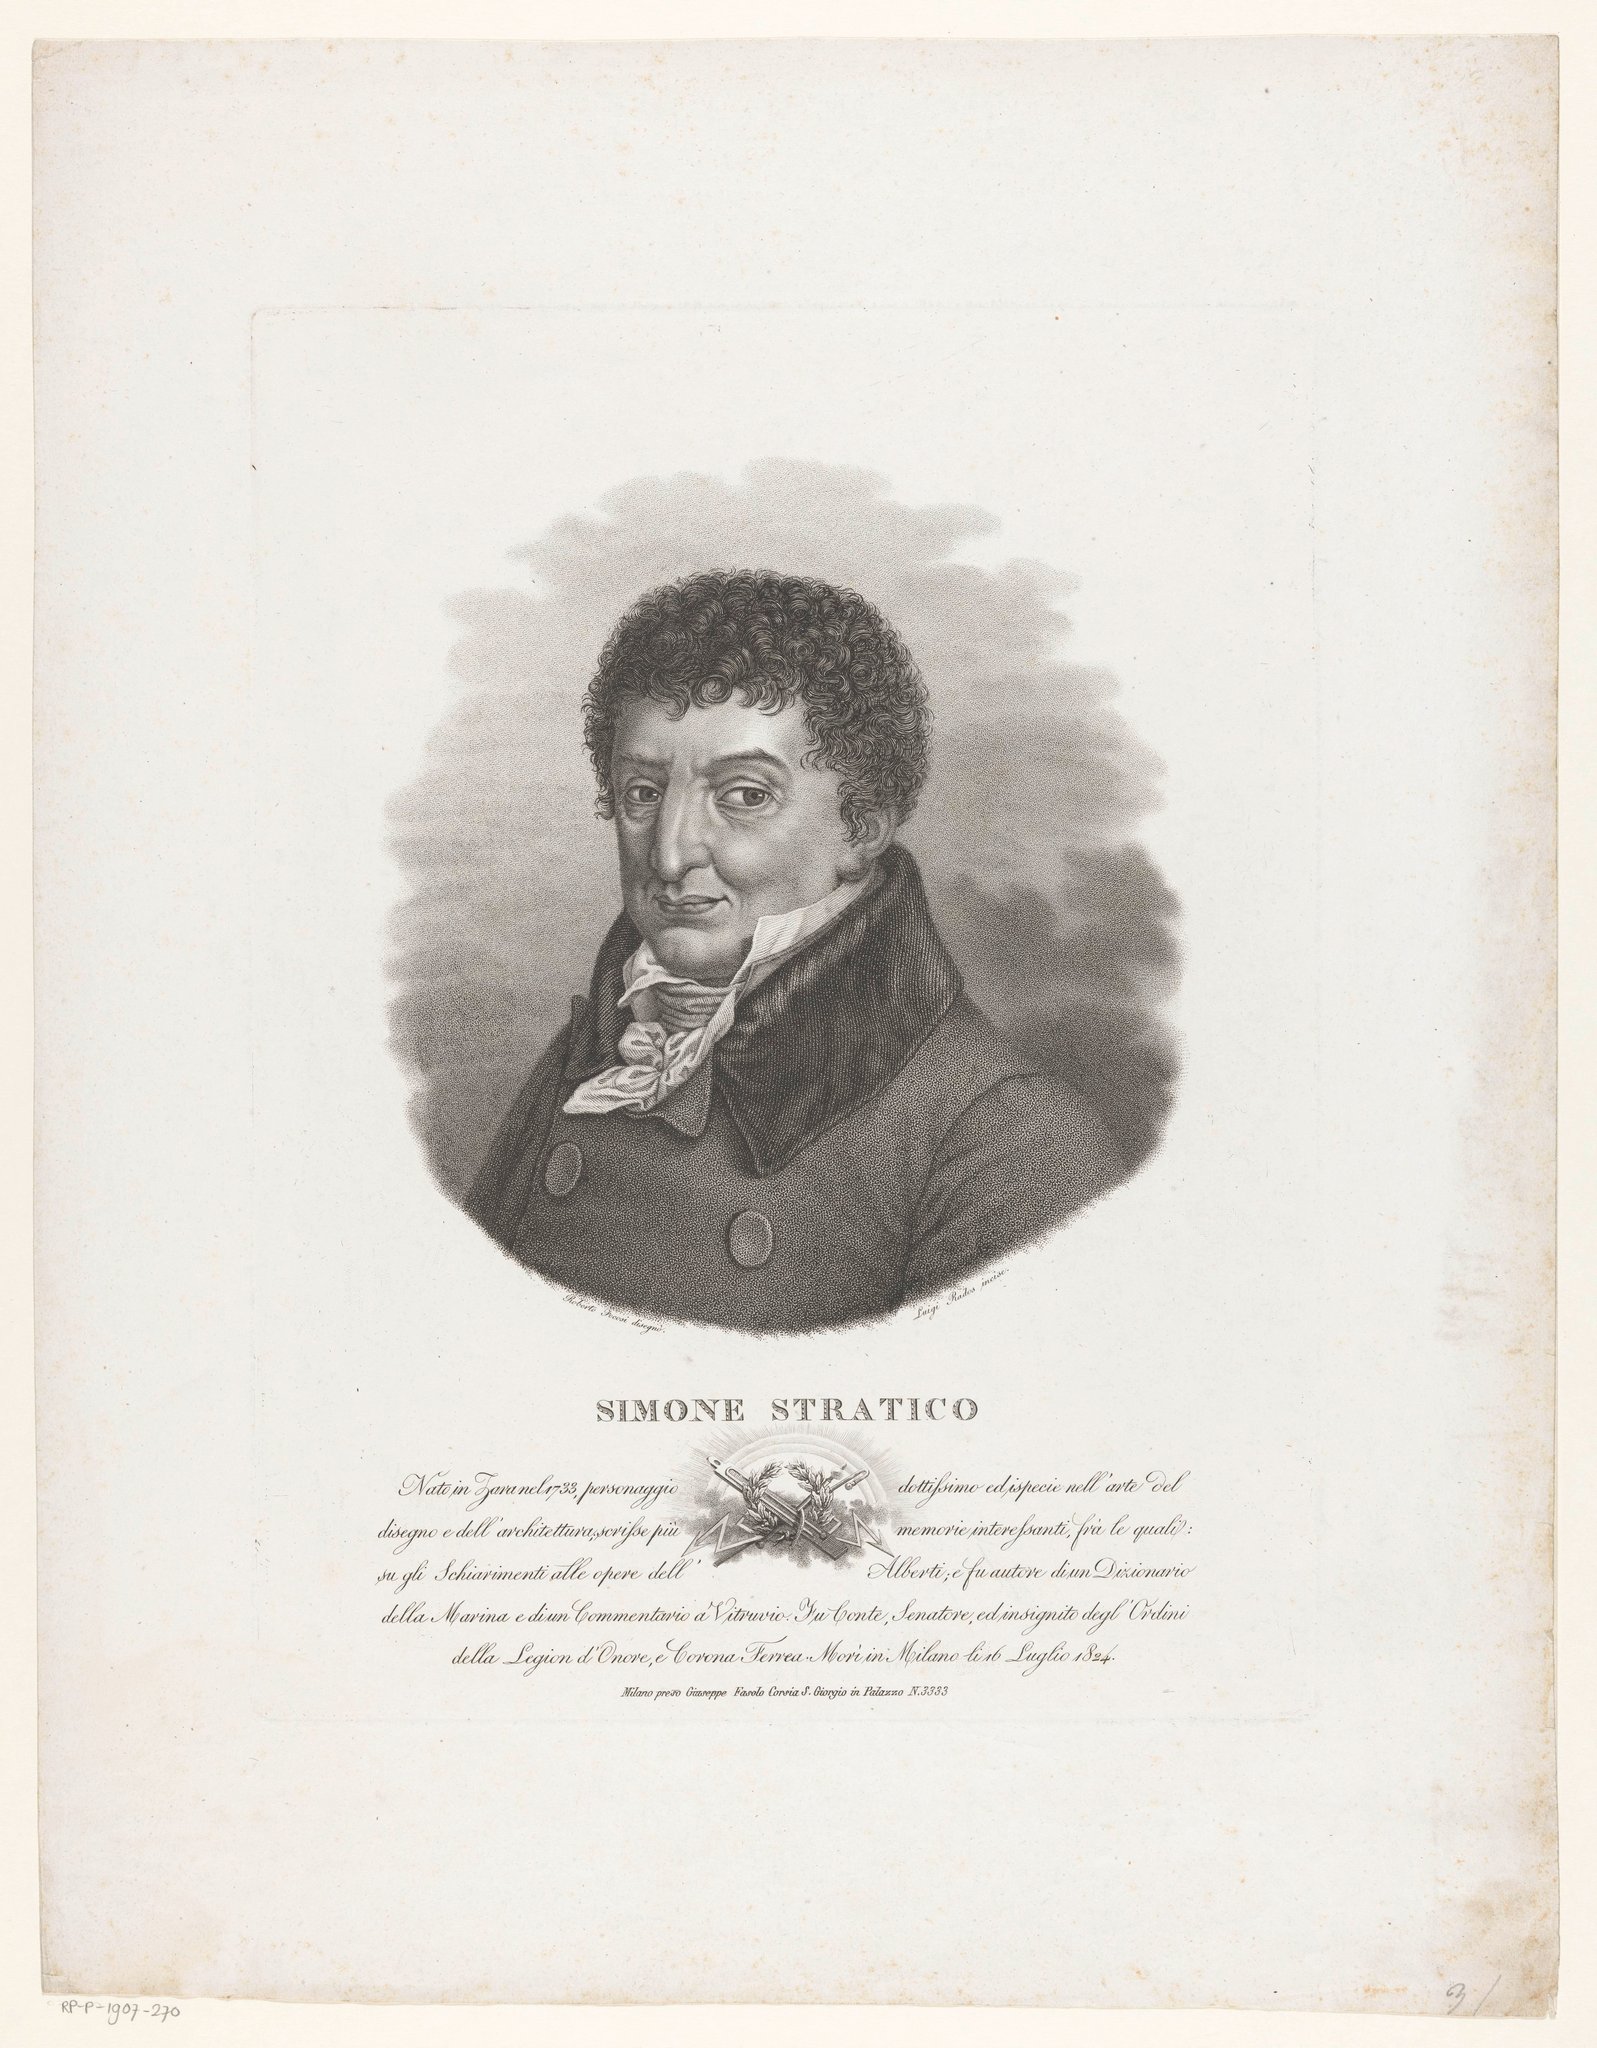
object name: print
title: Portret van Simone Stratico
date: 1783-1840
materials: paper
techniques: etching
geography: italy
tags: physicist, historical persons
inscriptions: collector's mark: Lugt 2228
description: Deze prent maakt deel uit van een reeks portretprenten.